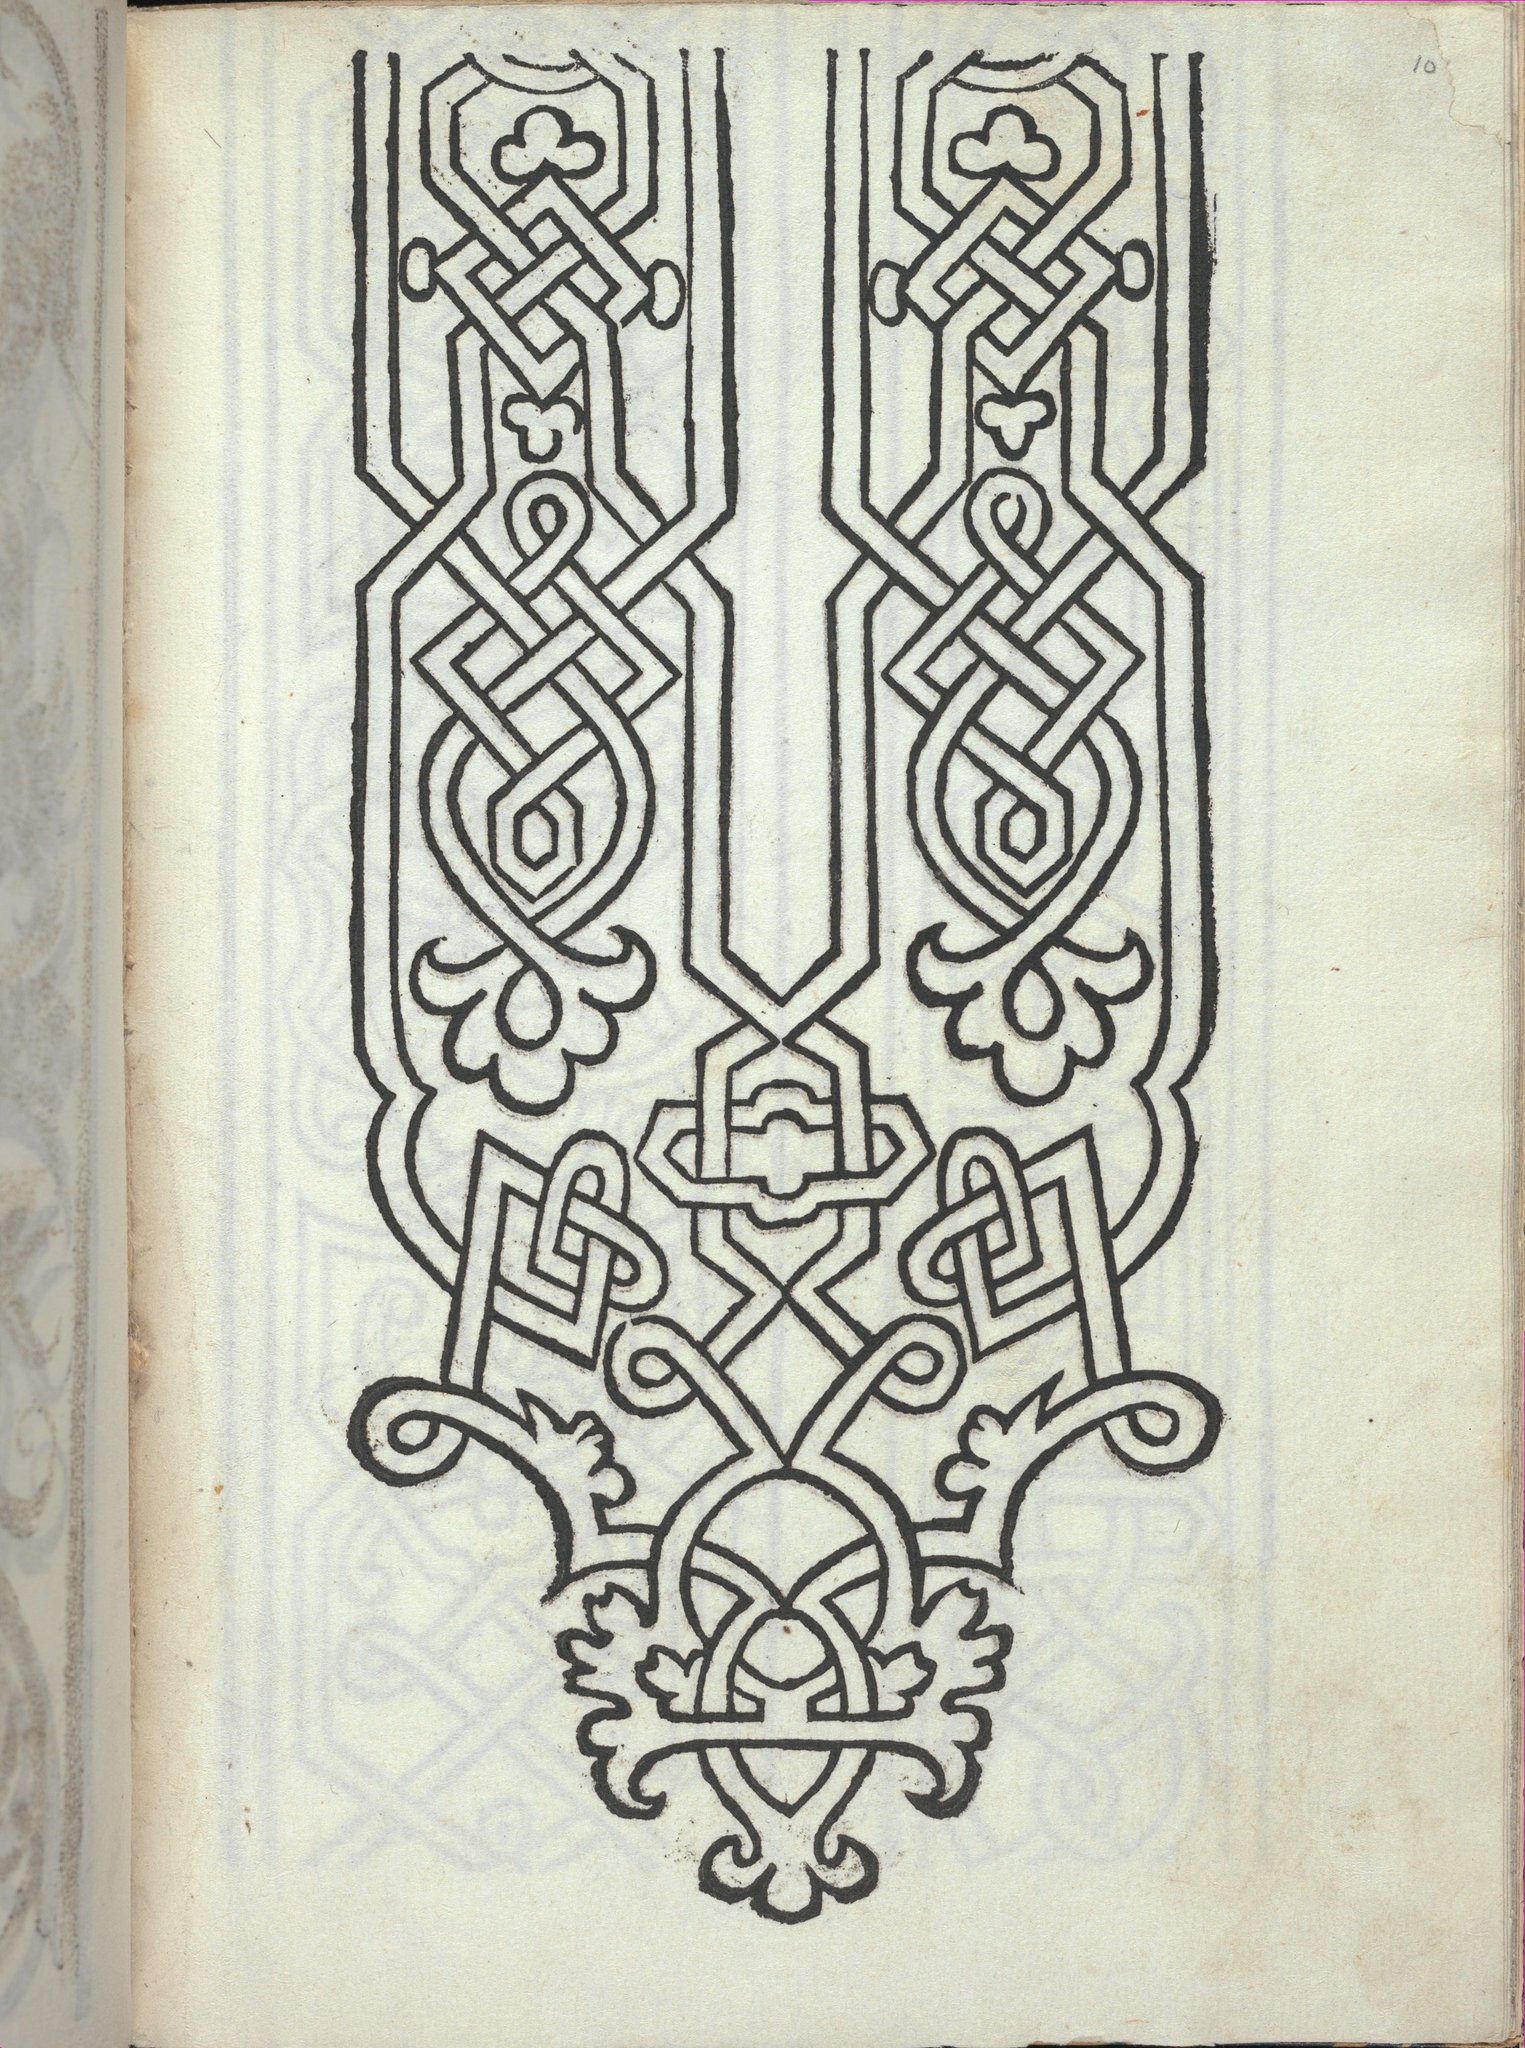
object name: book print ornament architecture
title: Libro quarto. De rechami per elquale se impara in diuersi modi lordine e il modo de recamare...Opera noua, page 10 (recto)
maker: alessandro paganino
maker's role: publisher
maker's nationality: italian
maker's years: 1500-1550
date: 1532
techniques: woodcut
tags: ornament